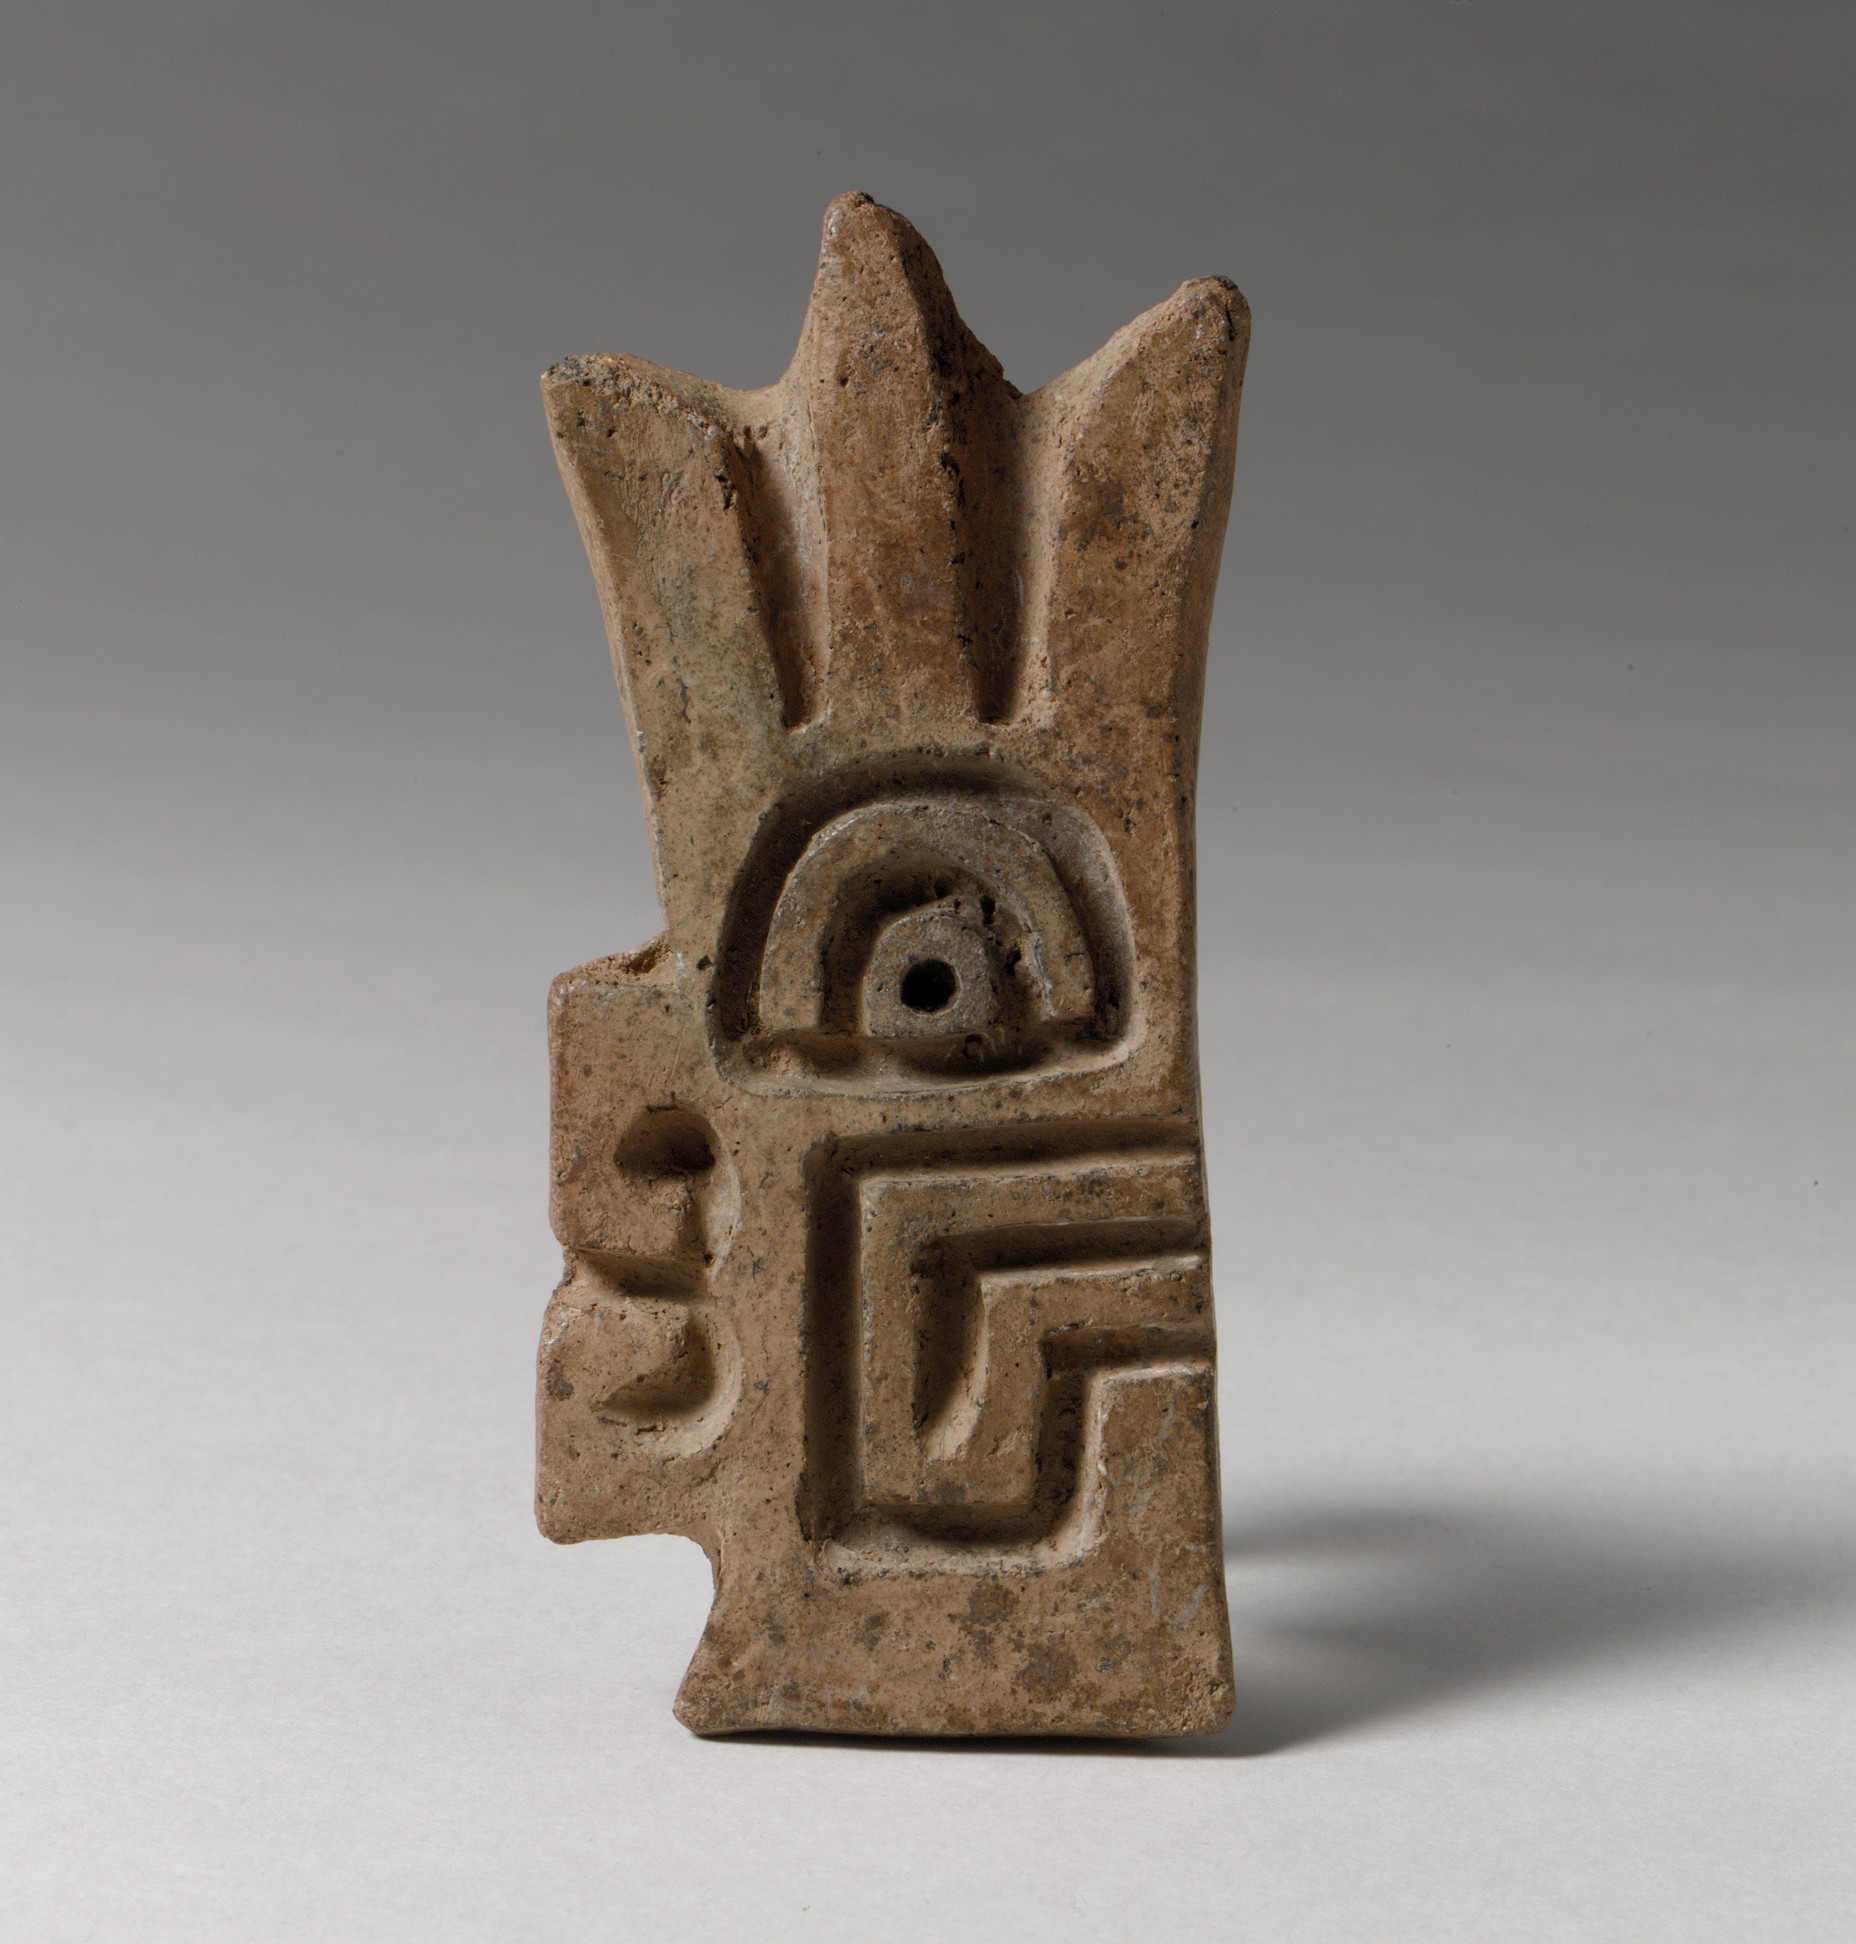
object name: stamp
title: Flat Stamp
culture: chavin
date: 700-101 BCE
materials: ceramic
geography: peru